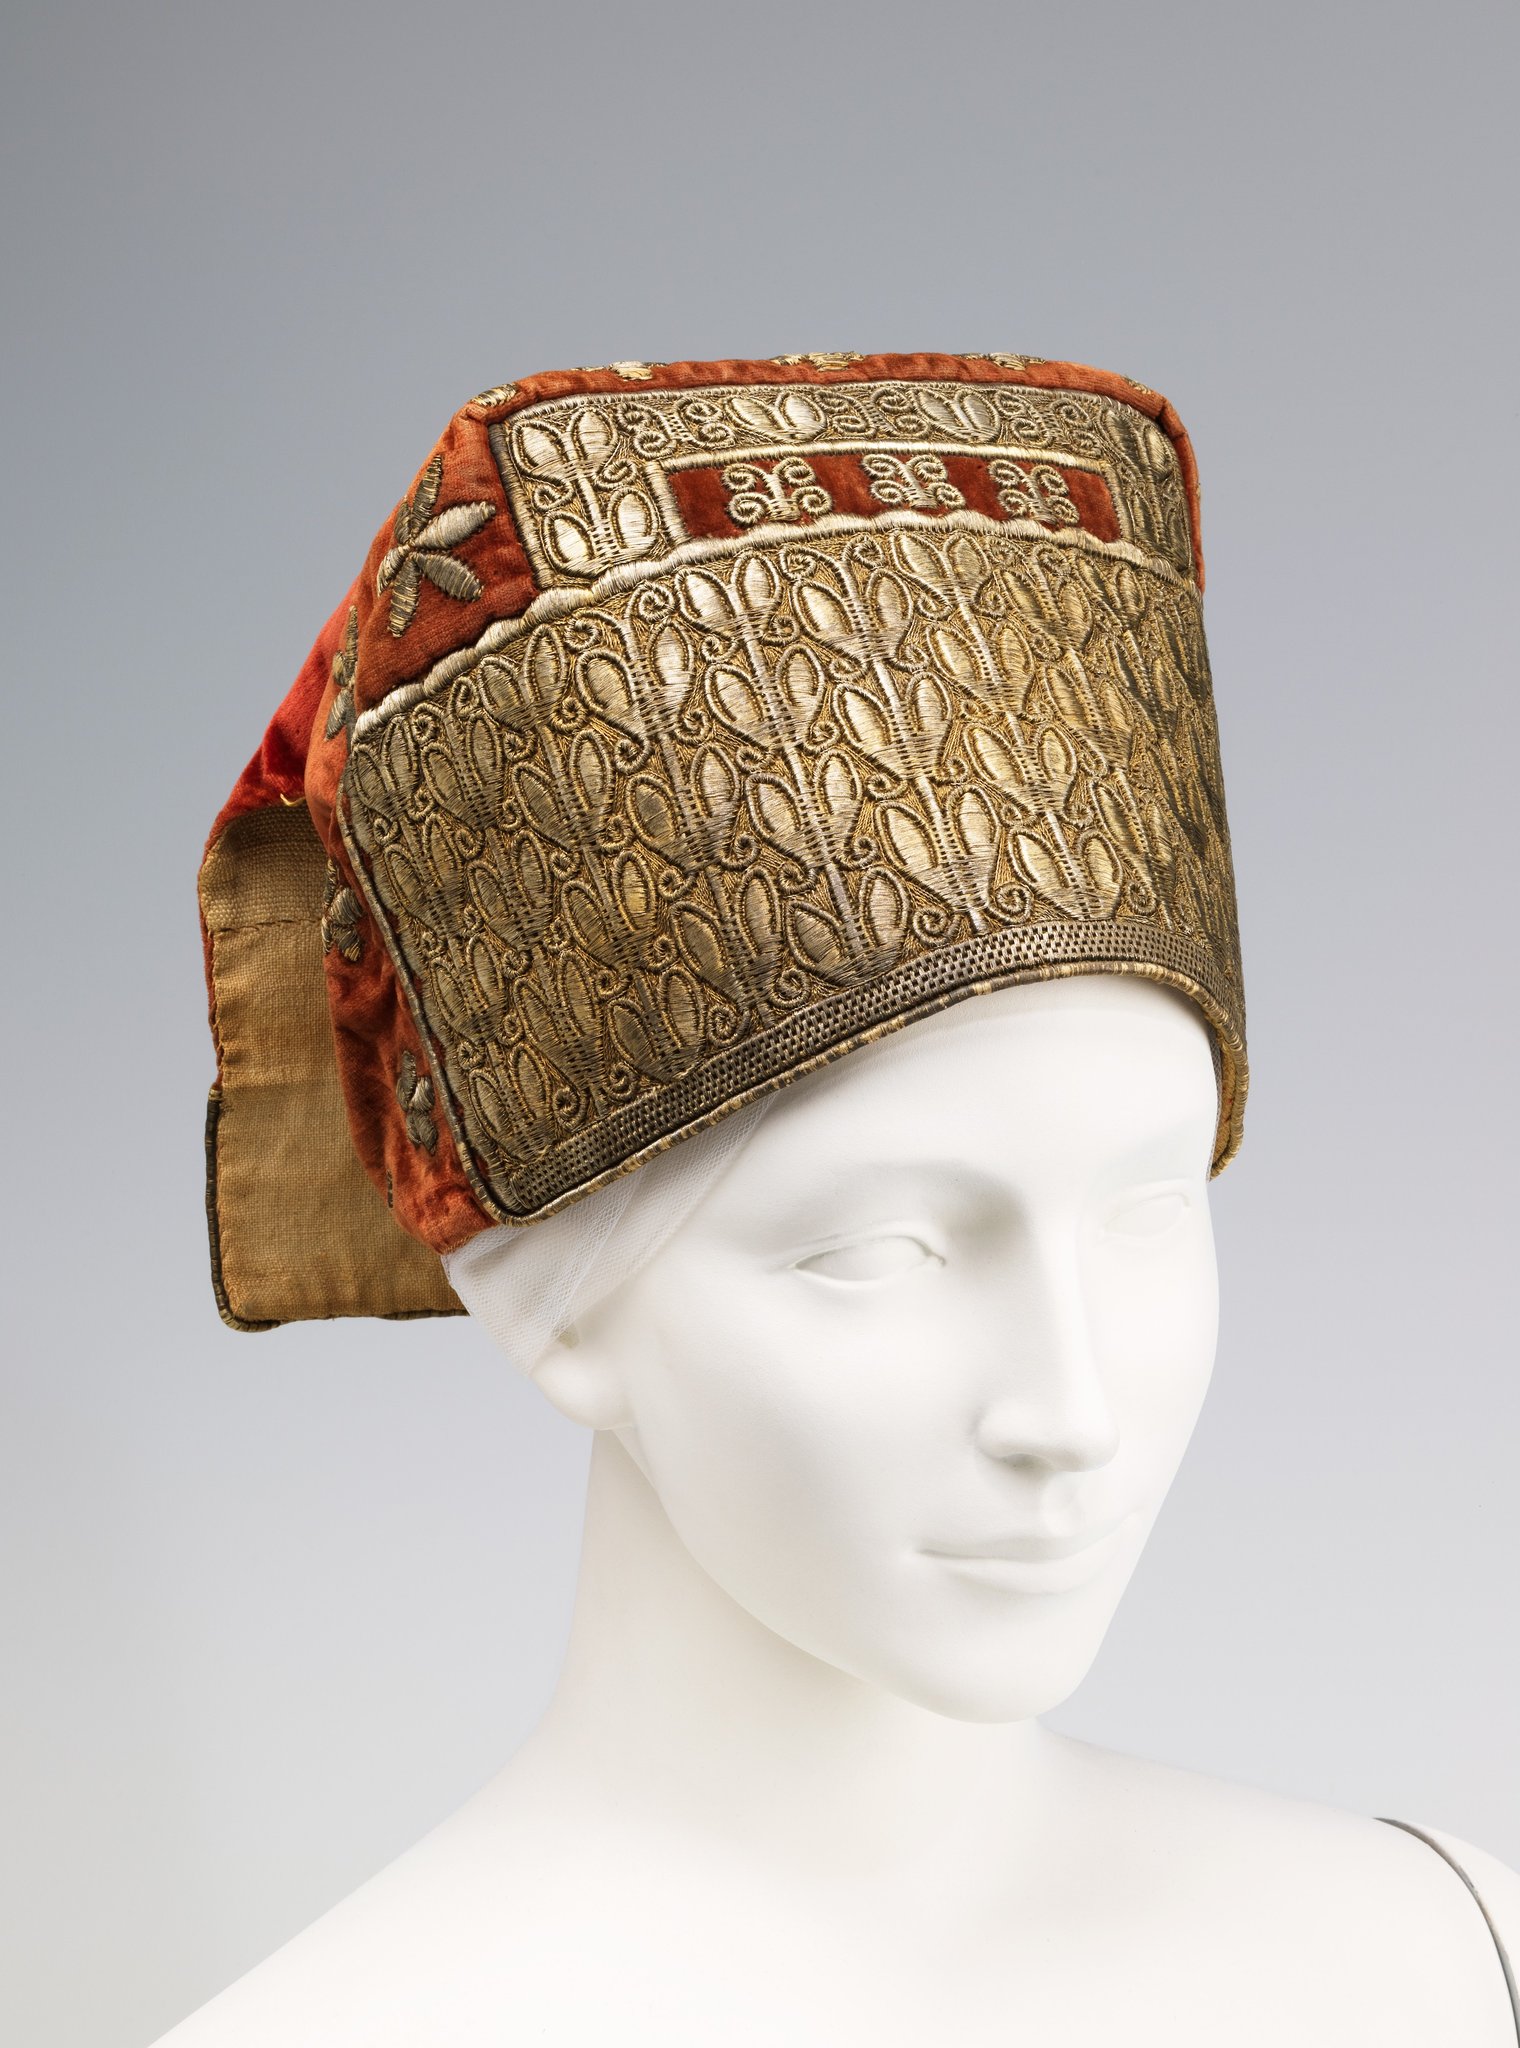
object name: hat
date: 1776-1800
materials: linen, metal, silk